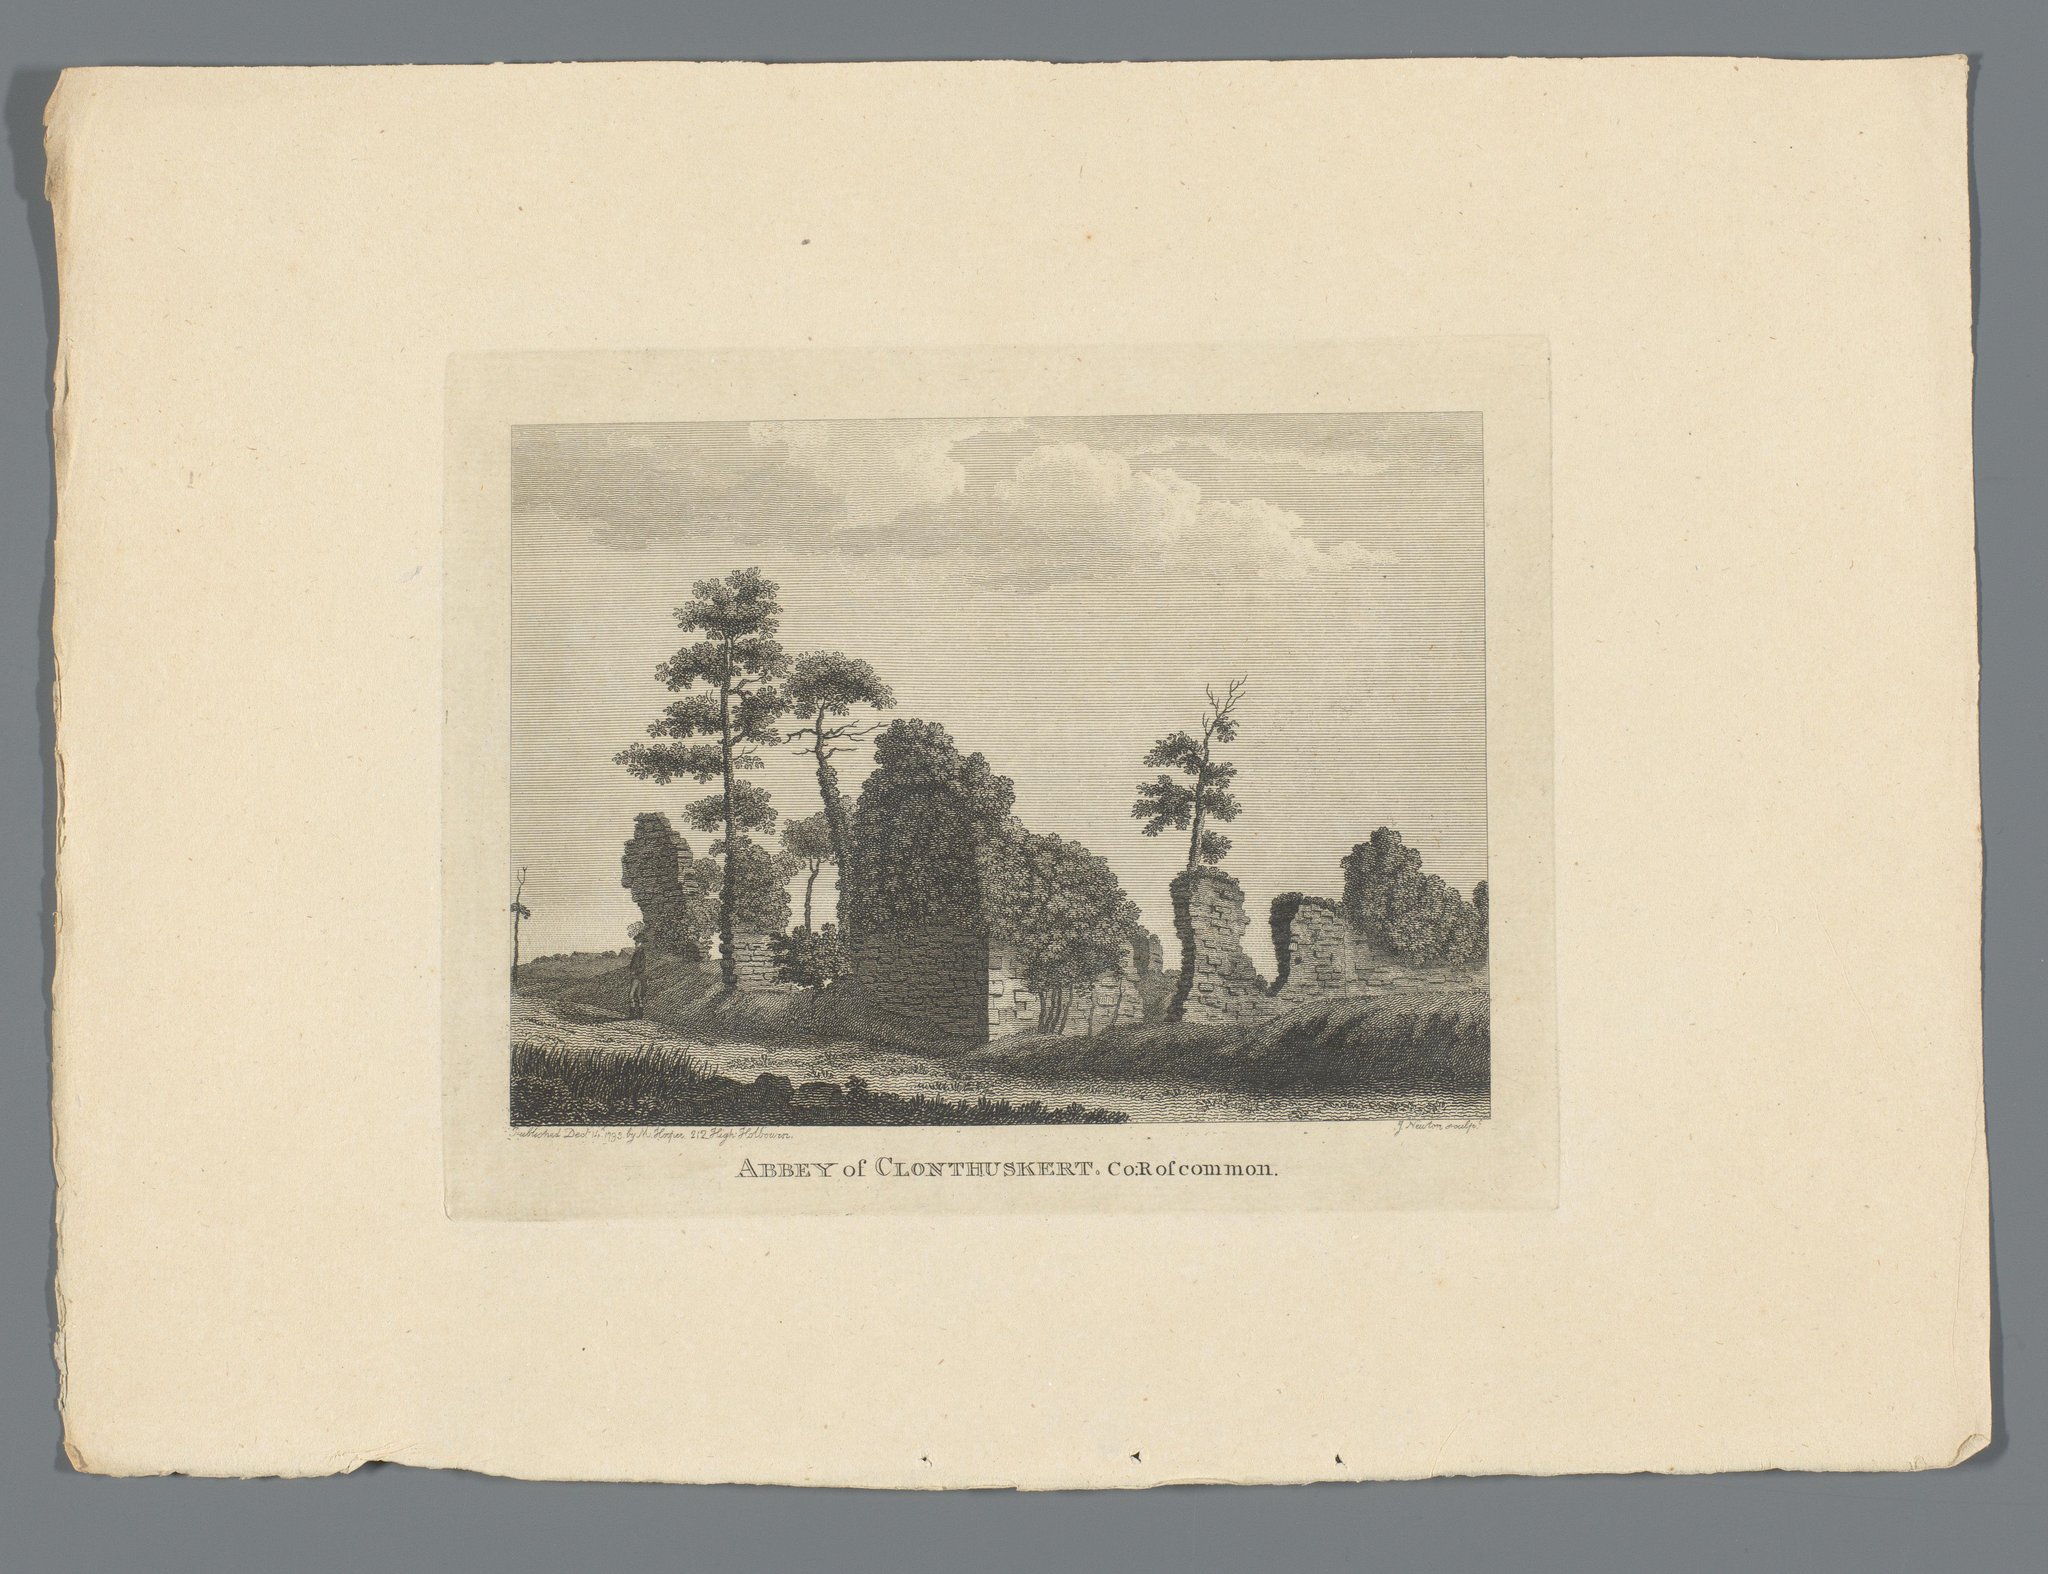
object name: book illustration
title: Gezicht op de ruïnes van de abdij van Clonthuskert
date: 1793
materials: paper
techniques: etching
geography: london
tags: abbey, monastery, convent ~ roman catholic church, landscape with ruins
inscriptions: date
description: Prent verschenen in: Grose, Francis. The antiquities of Ireland, dl. 2. Londen: S. Hooper, 1795.